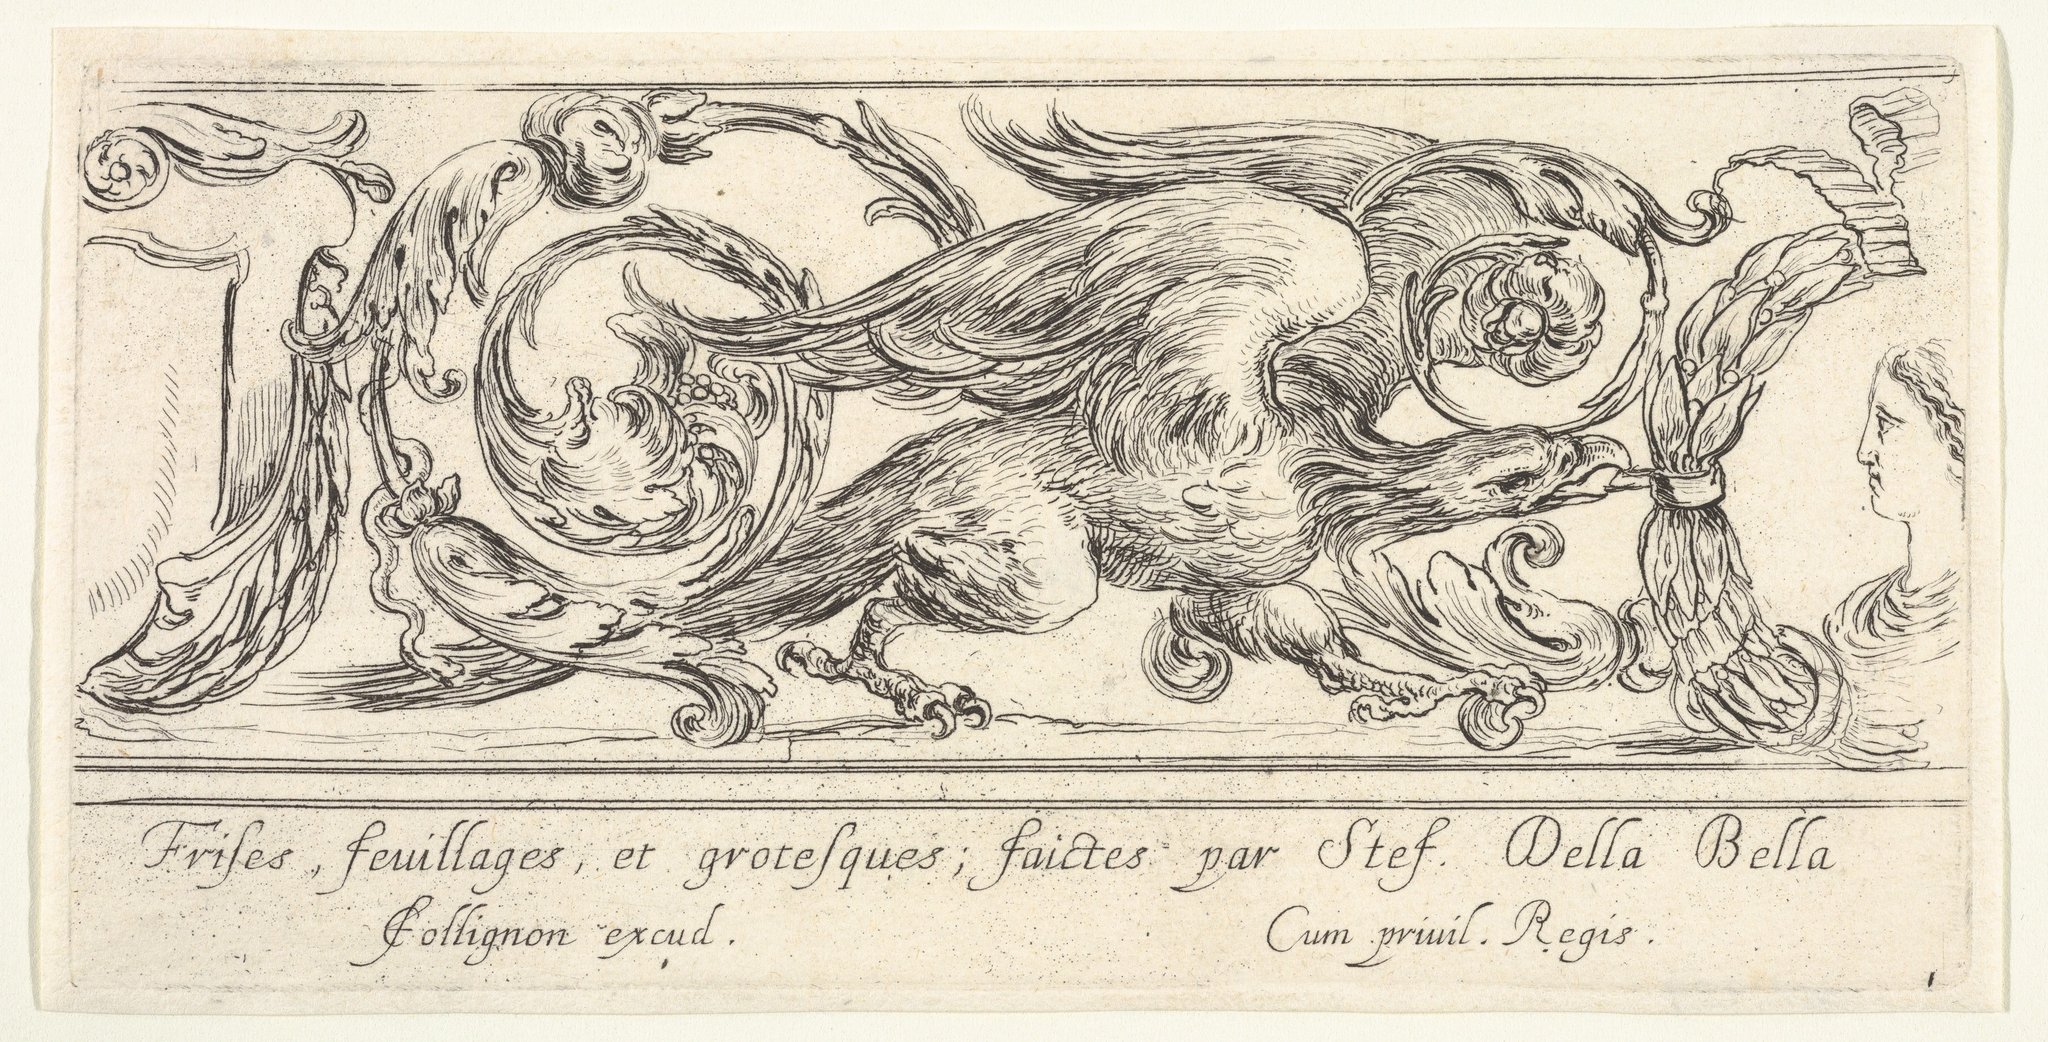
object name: print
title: An eagle walking towards the right, a bust of a woman to right turned in profile towards the left, plate 1 from "Friezes, foliage, and grotesques" (Frises, feuillages et grotesques)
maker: stefano della bella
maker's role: artist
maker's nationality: italian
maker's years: 1610-1664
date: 1638-1643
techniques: etching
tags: eagles,profiles,women